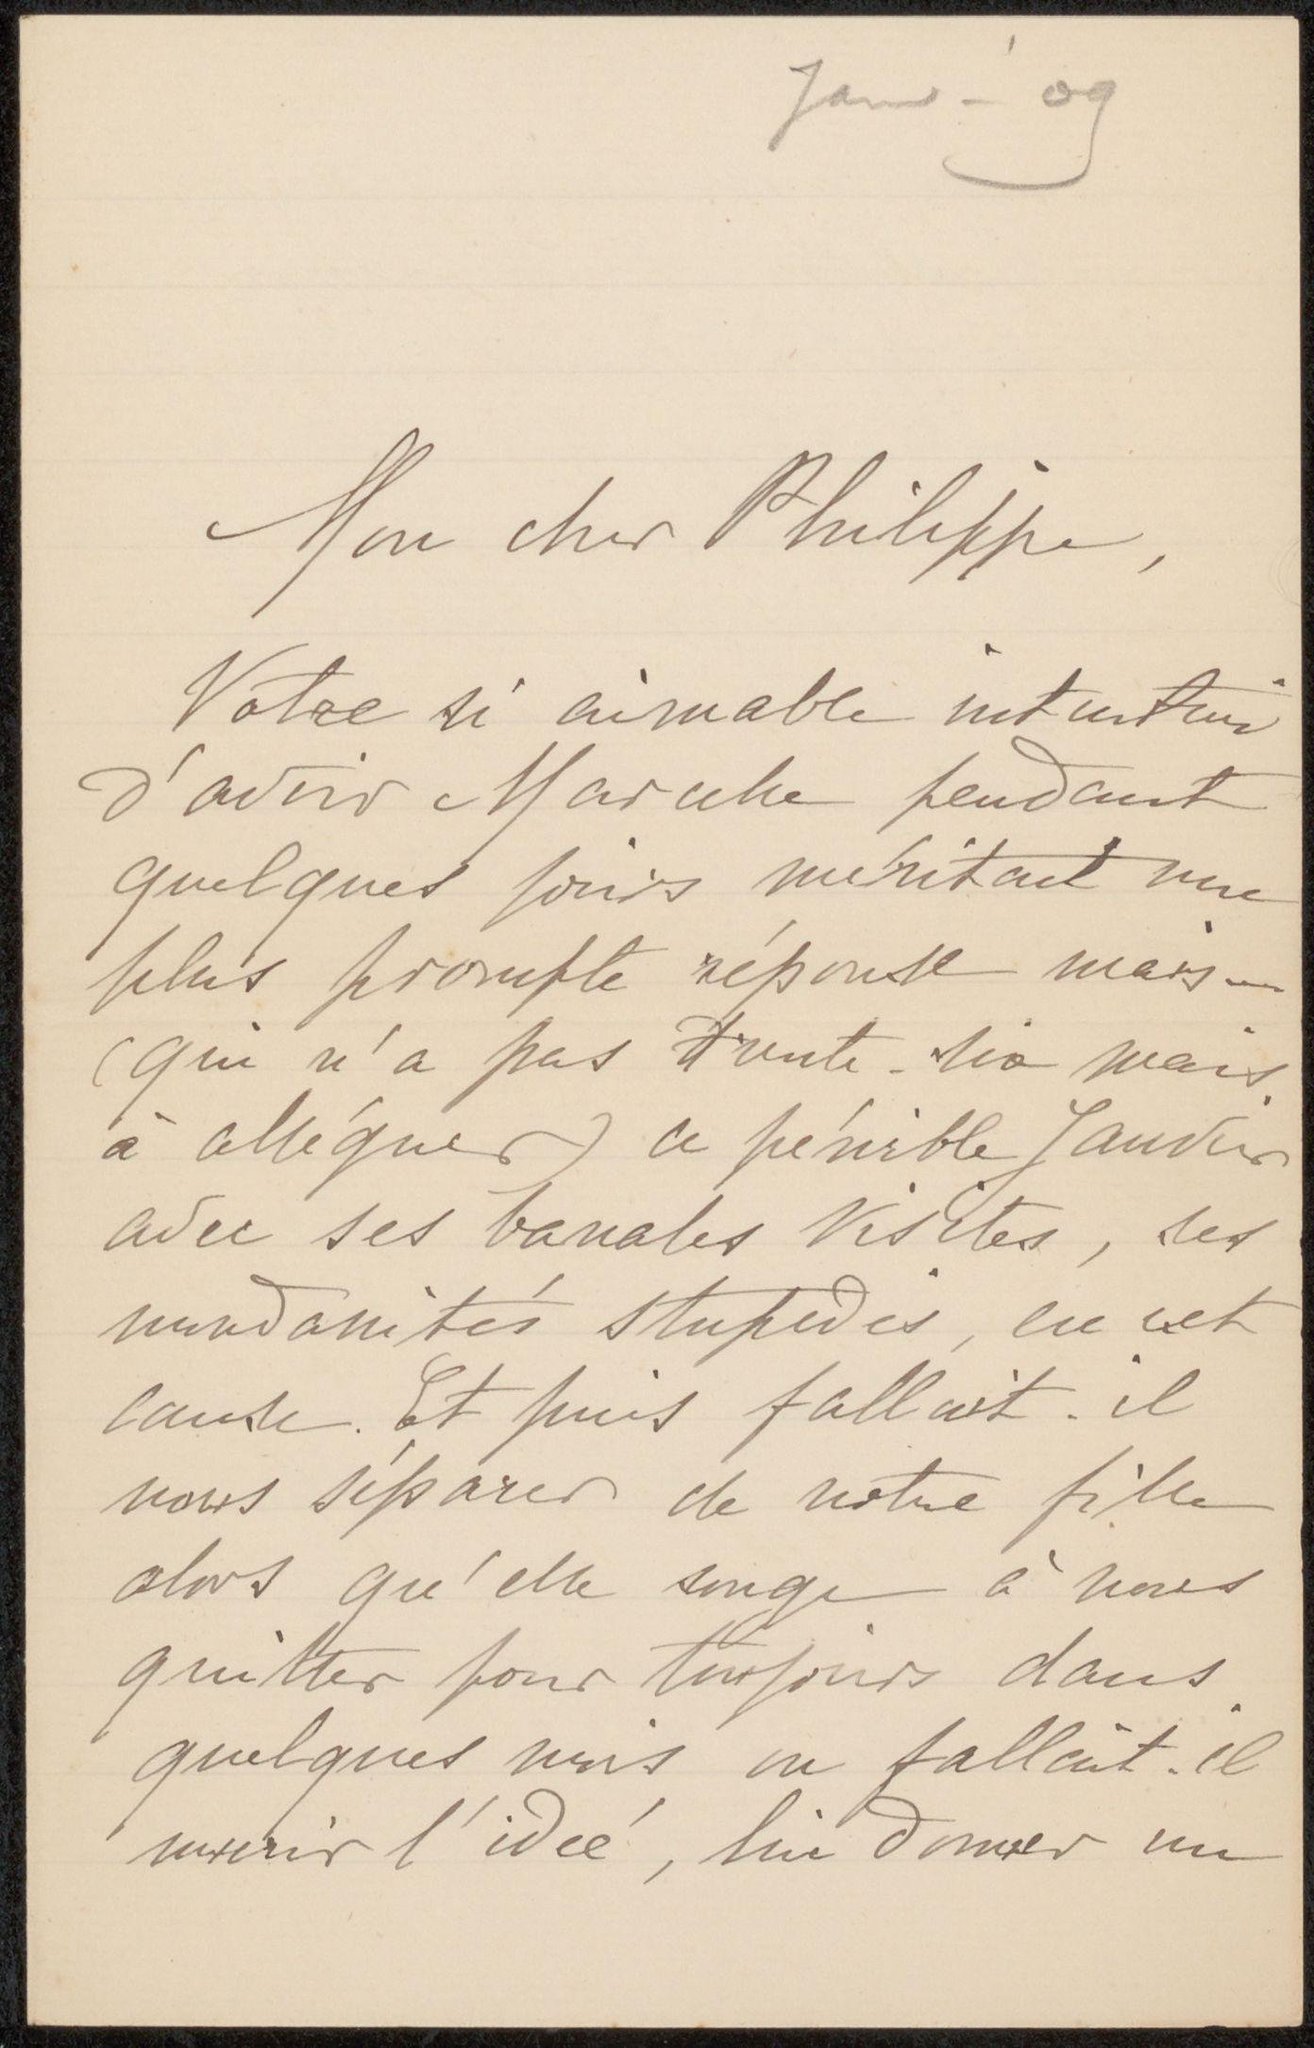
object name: letter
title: Brief aan Philip Zilcken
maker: jeanne boels de buck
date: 1909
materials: ink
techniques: pen, writing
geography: brussels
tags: the hague, painter, draughtsman, philip zilcken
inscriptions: collector's mark: ‘RPK’